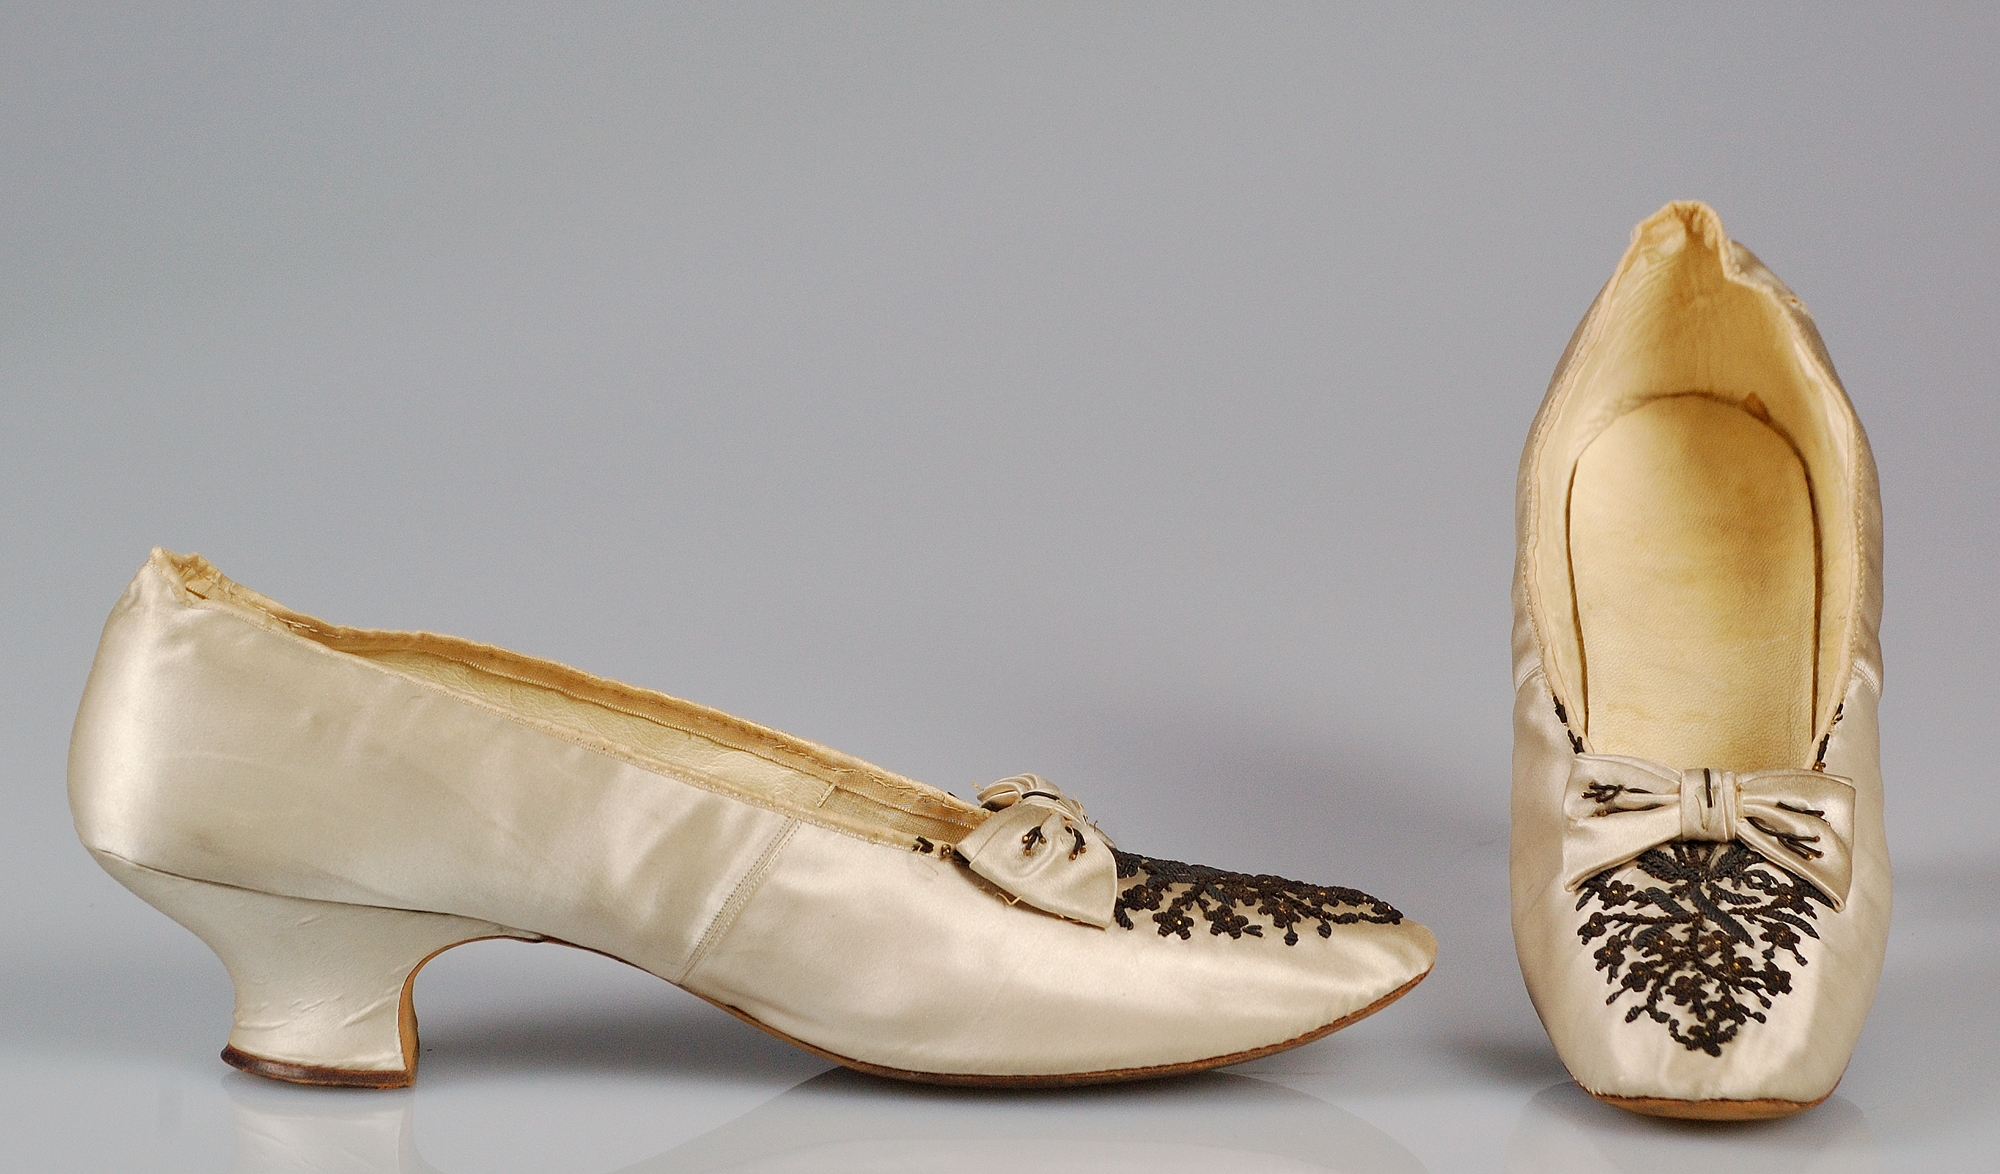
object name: evening slipper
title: Evening slippers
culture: french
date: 1875-1885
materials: silk